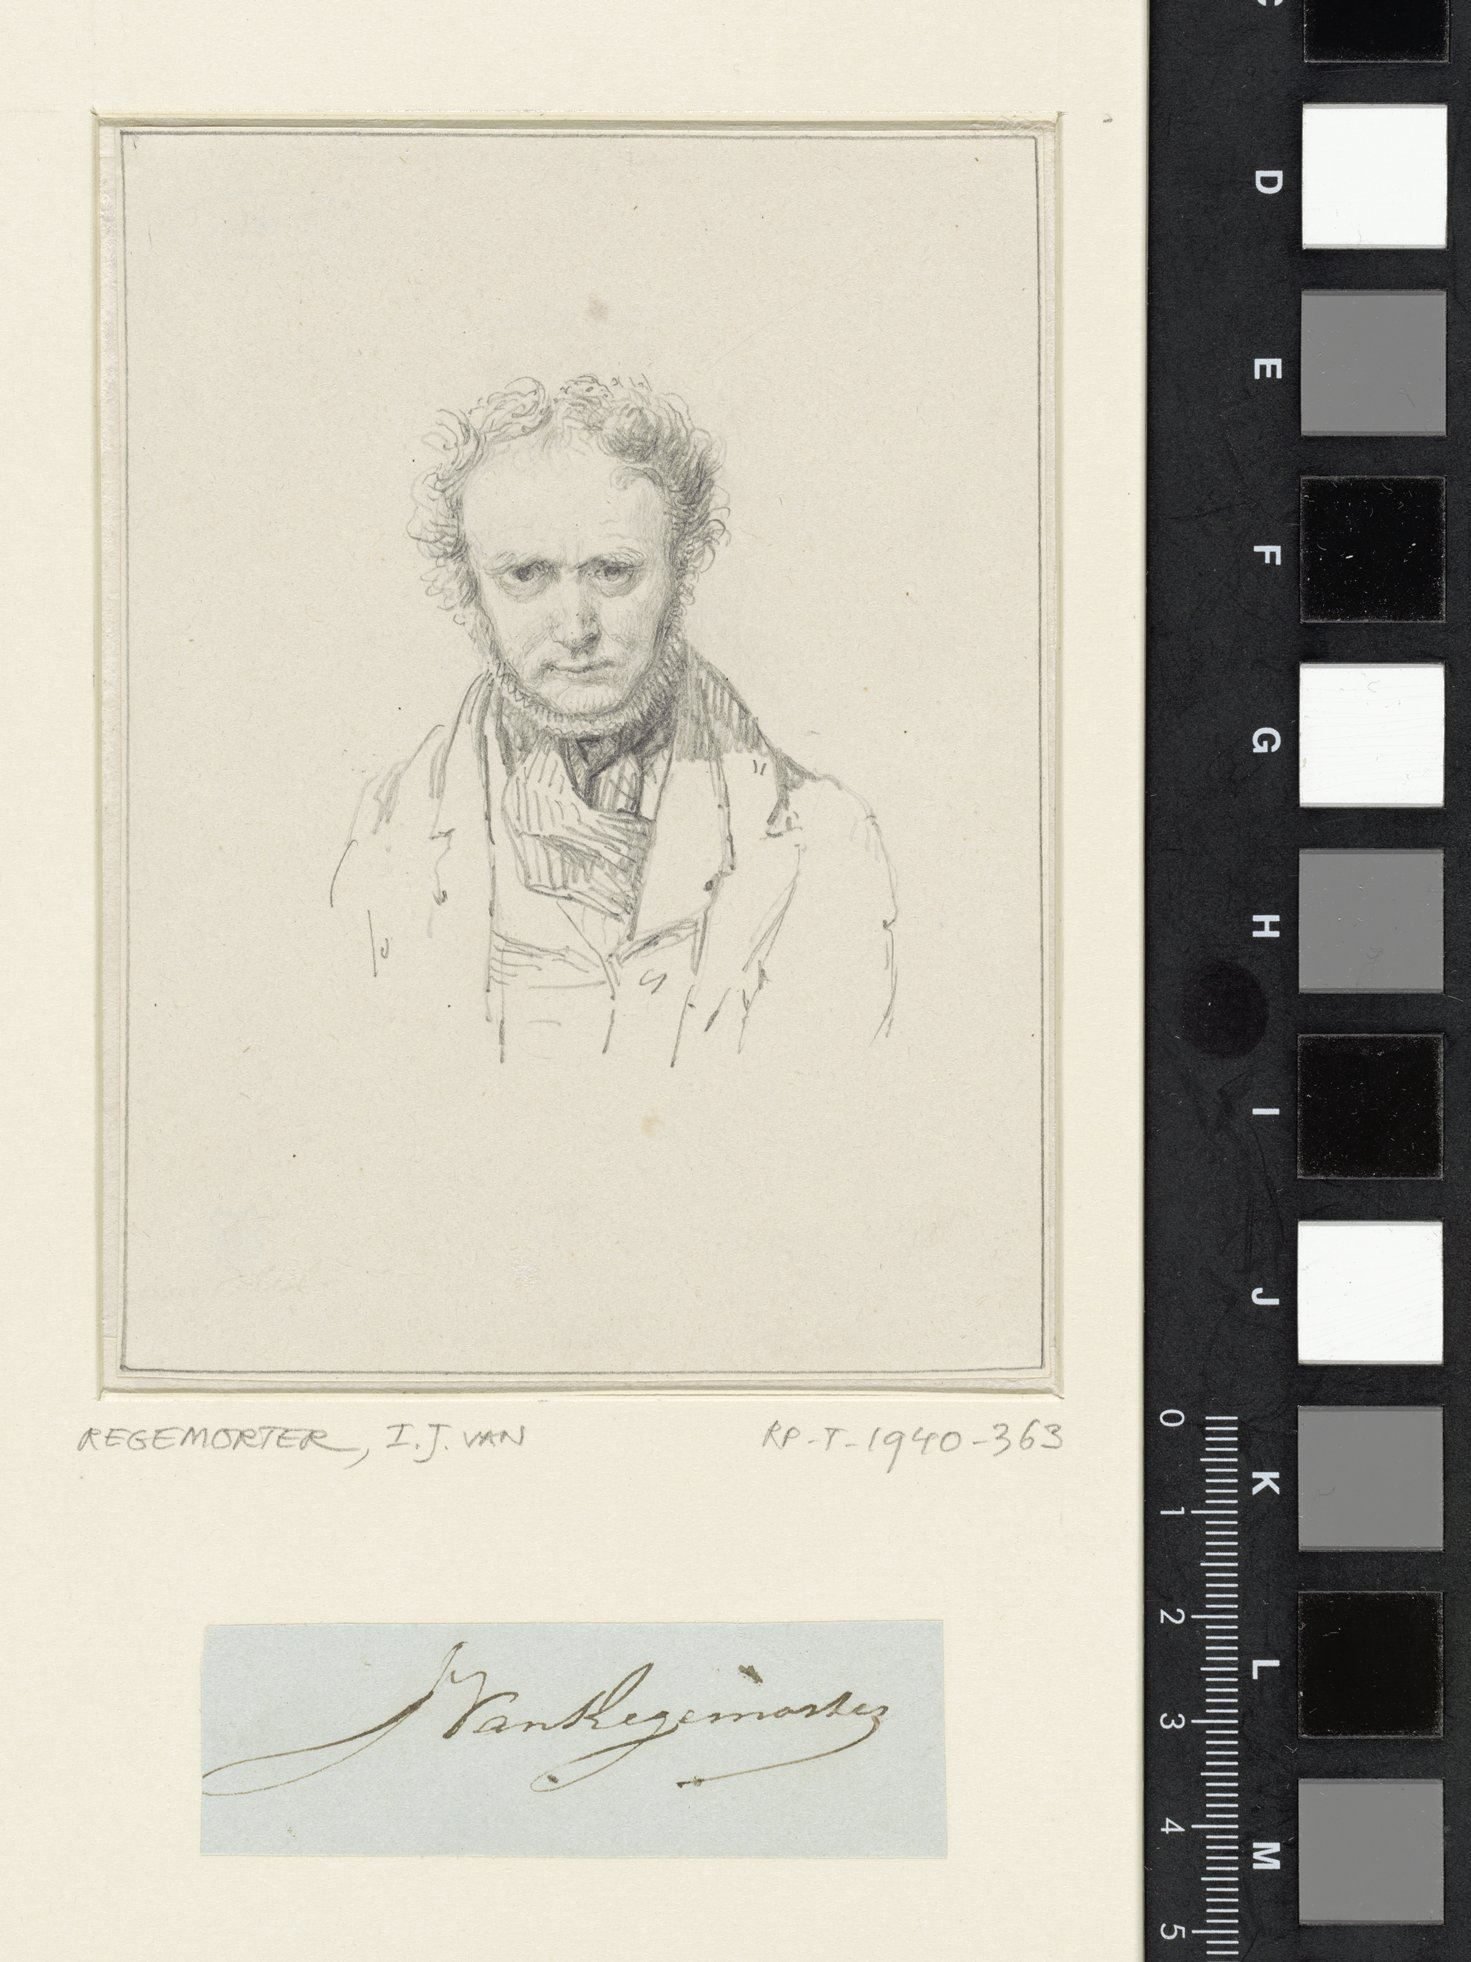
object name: drawing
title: Zelfportret van Ignatius Josephus van Regemorter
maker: ignatius josephus van regemorter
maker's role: conservator, painter, print maker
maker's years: 1785-1873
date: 1795-1873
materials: paper, pencil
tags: antwerp, painter, print maker, conservator, ignatius josephus van regemorter, historical persons, portrait, self-portrait of artist